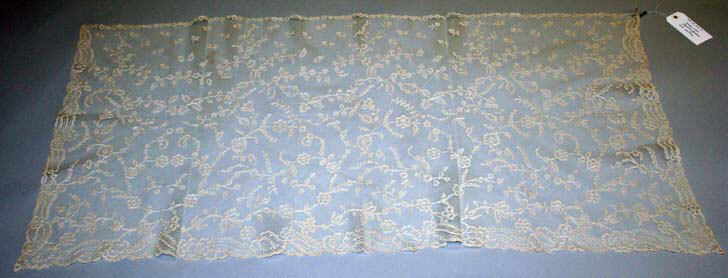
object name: veil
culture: british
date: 1801-1900